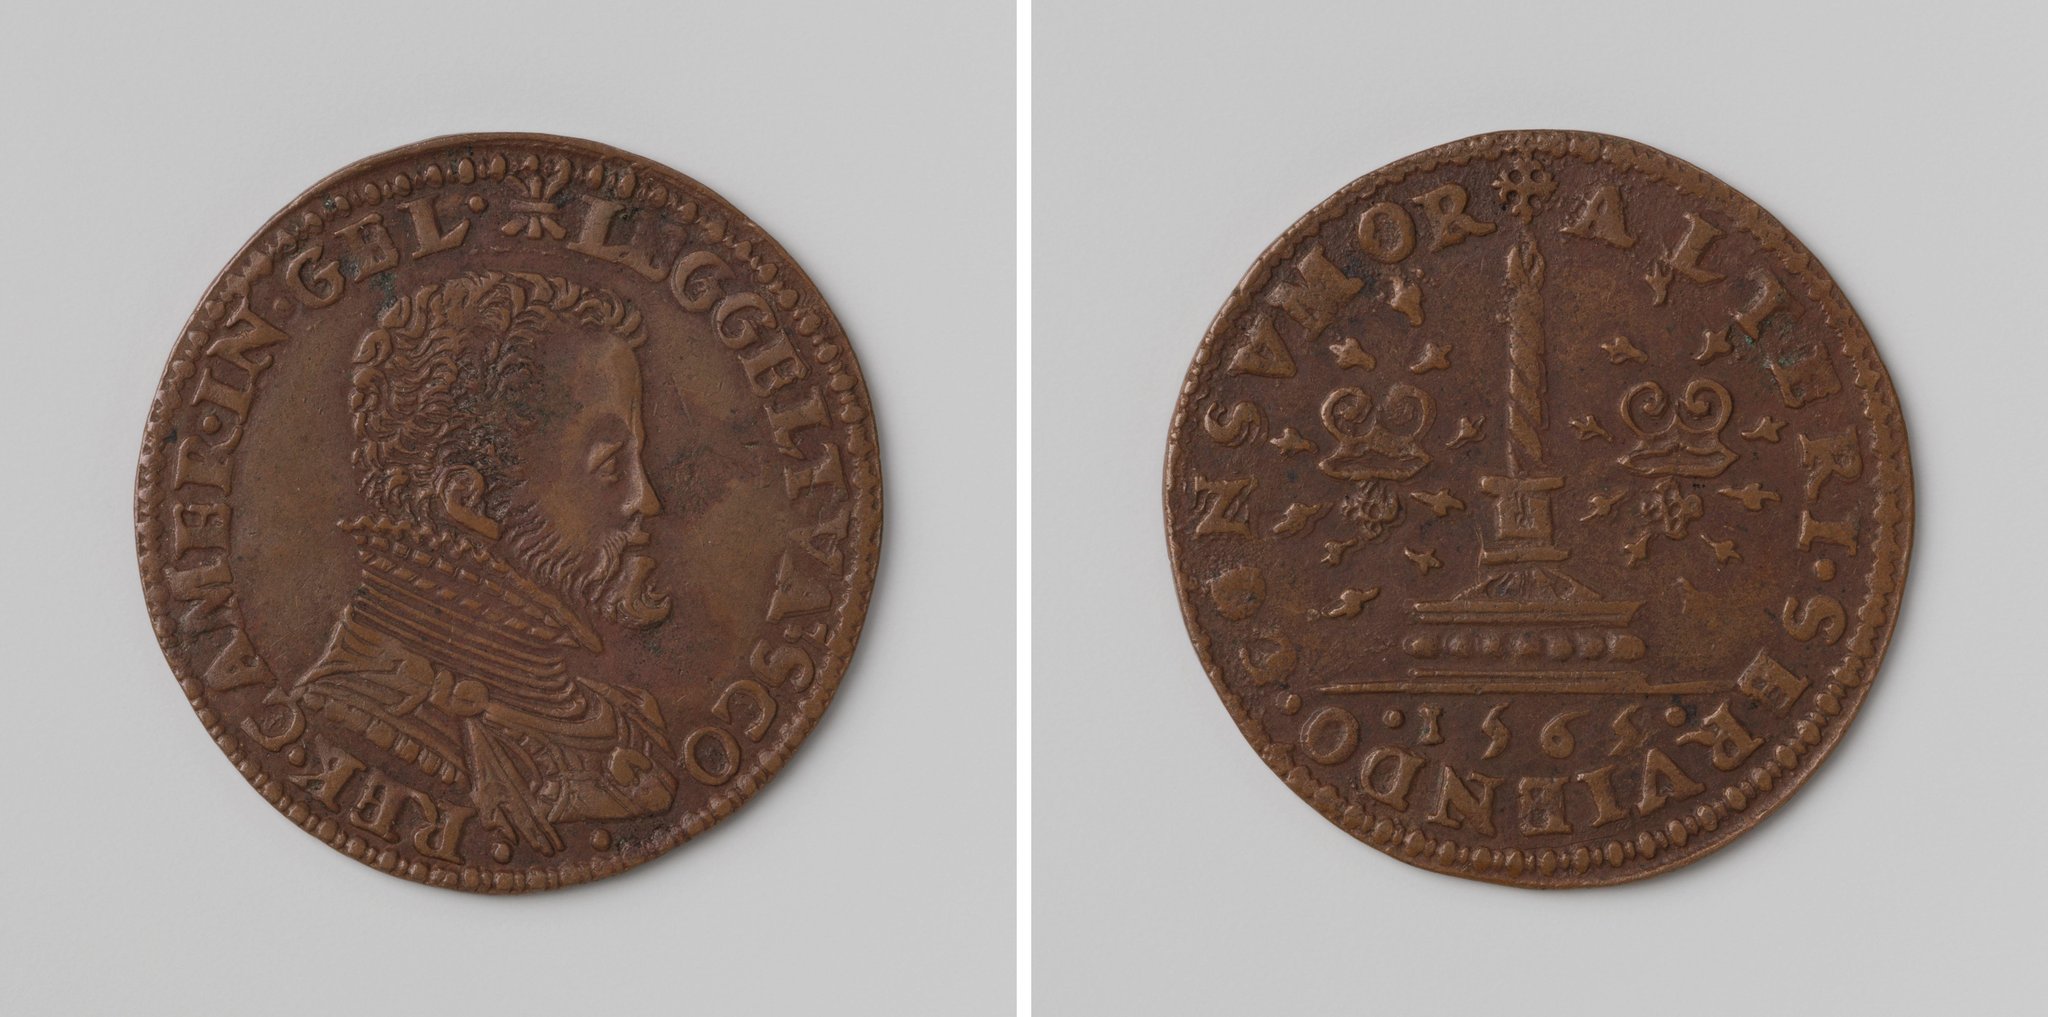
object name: jeton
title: Filips II, koning van Spanje, rekenpenning van de rekenkamer van Gelderland te Arnhem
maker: Anonymous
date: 1565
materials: copper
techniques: striking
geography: netherlands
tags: philip ii of spain, arnhem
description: Koperen penning. Voorzijde: borststuk man binnen omschrift. Keerzijde: brandende kaars tussen twee vuurslagen, waar vonken uit schieten binnen omschrift; afsnede: jaartal